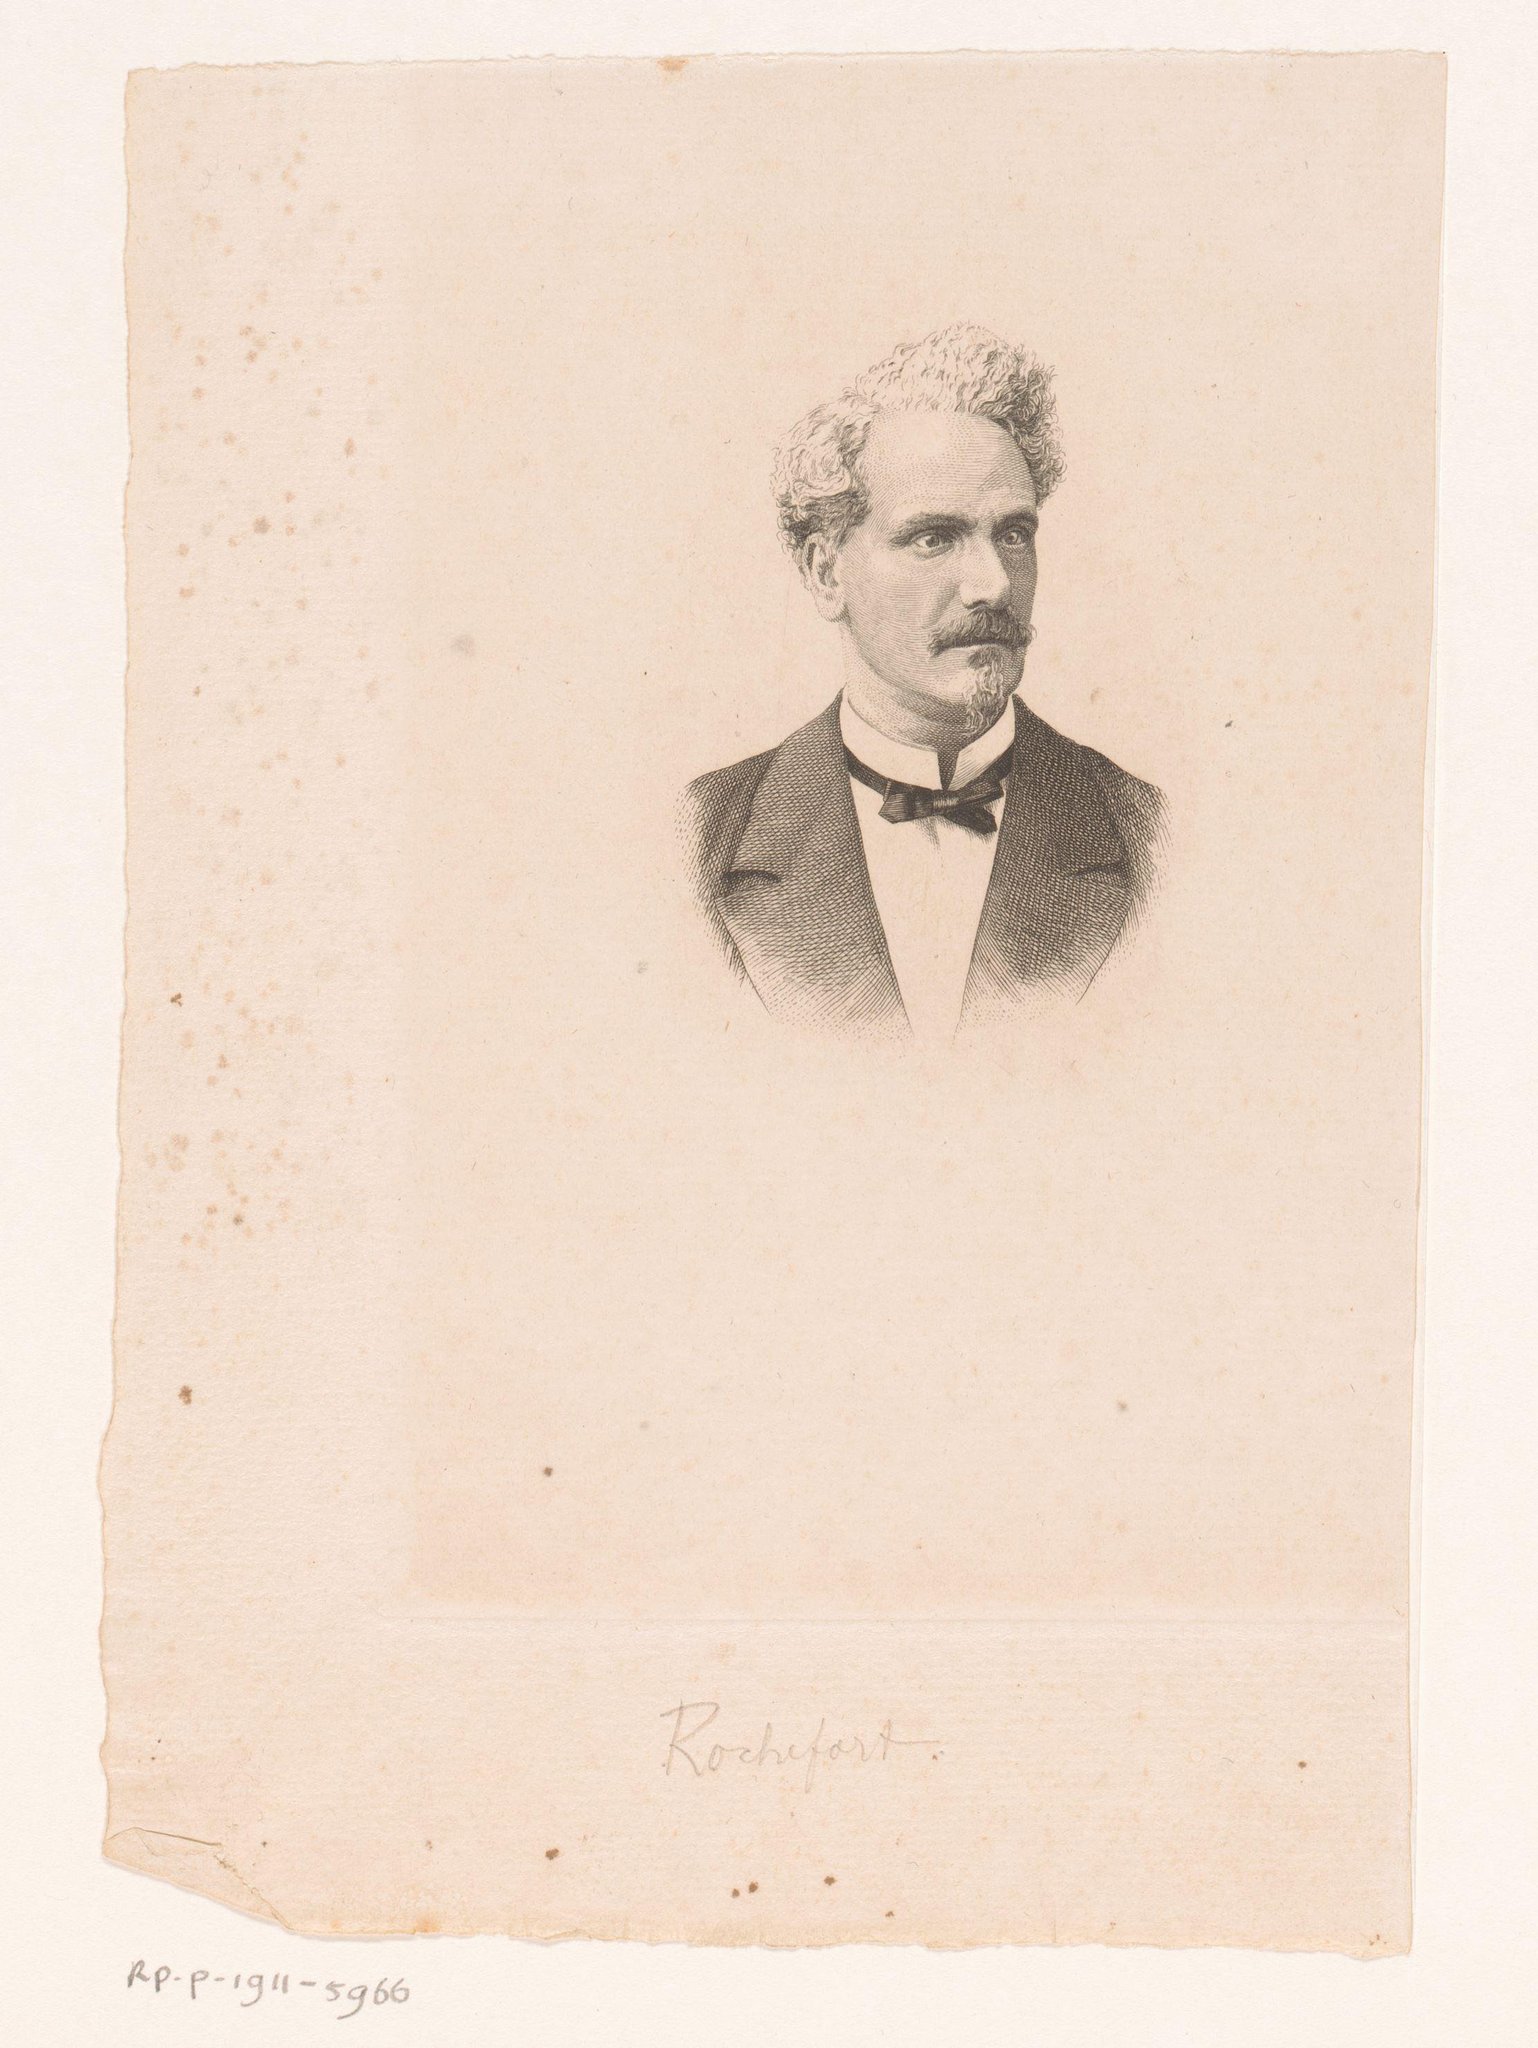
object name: print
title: Portret van een onbekende man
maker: louis le nain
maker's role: print maker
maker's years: 1851-1939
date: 1861-1911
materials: paper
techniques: etching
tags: adult man, historical persons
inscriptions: collector's mark: Lugt 2228, inscription: ‘Rochefort’